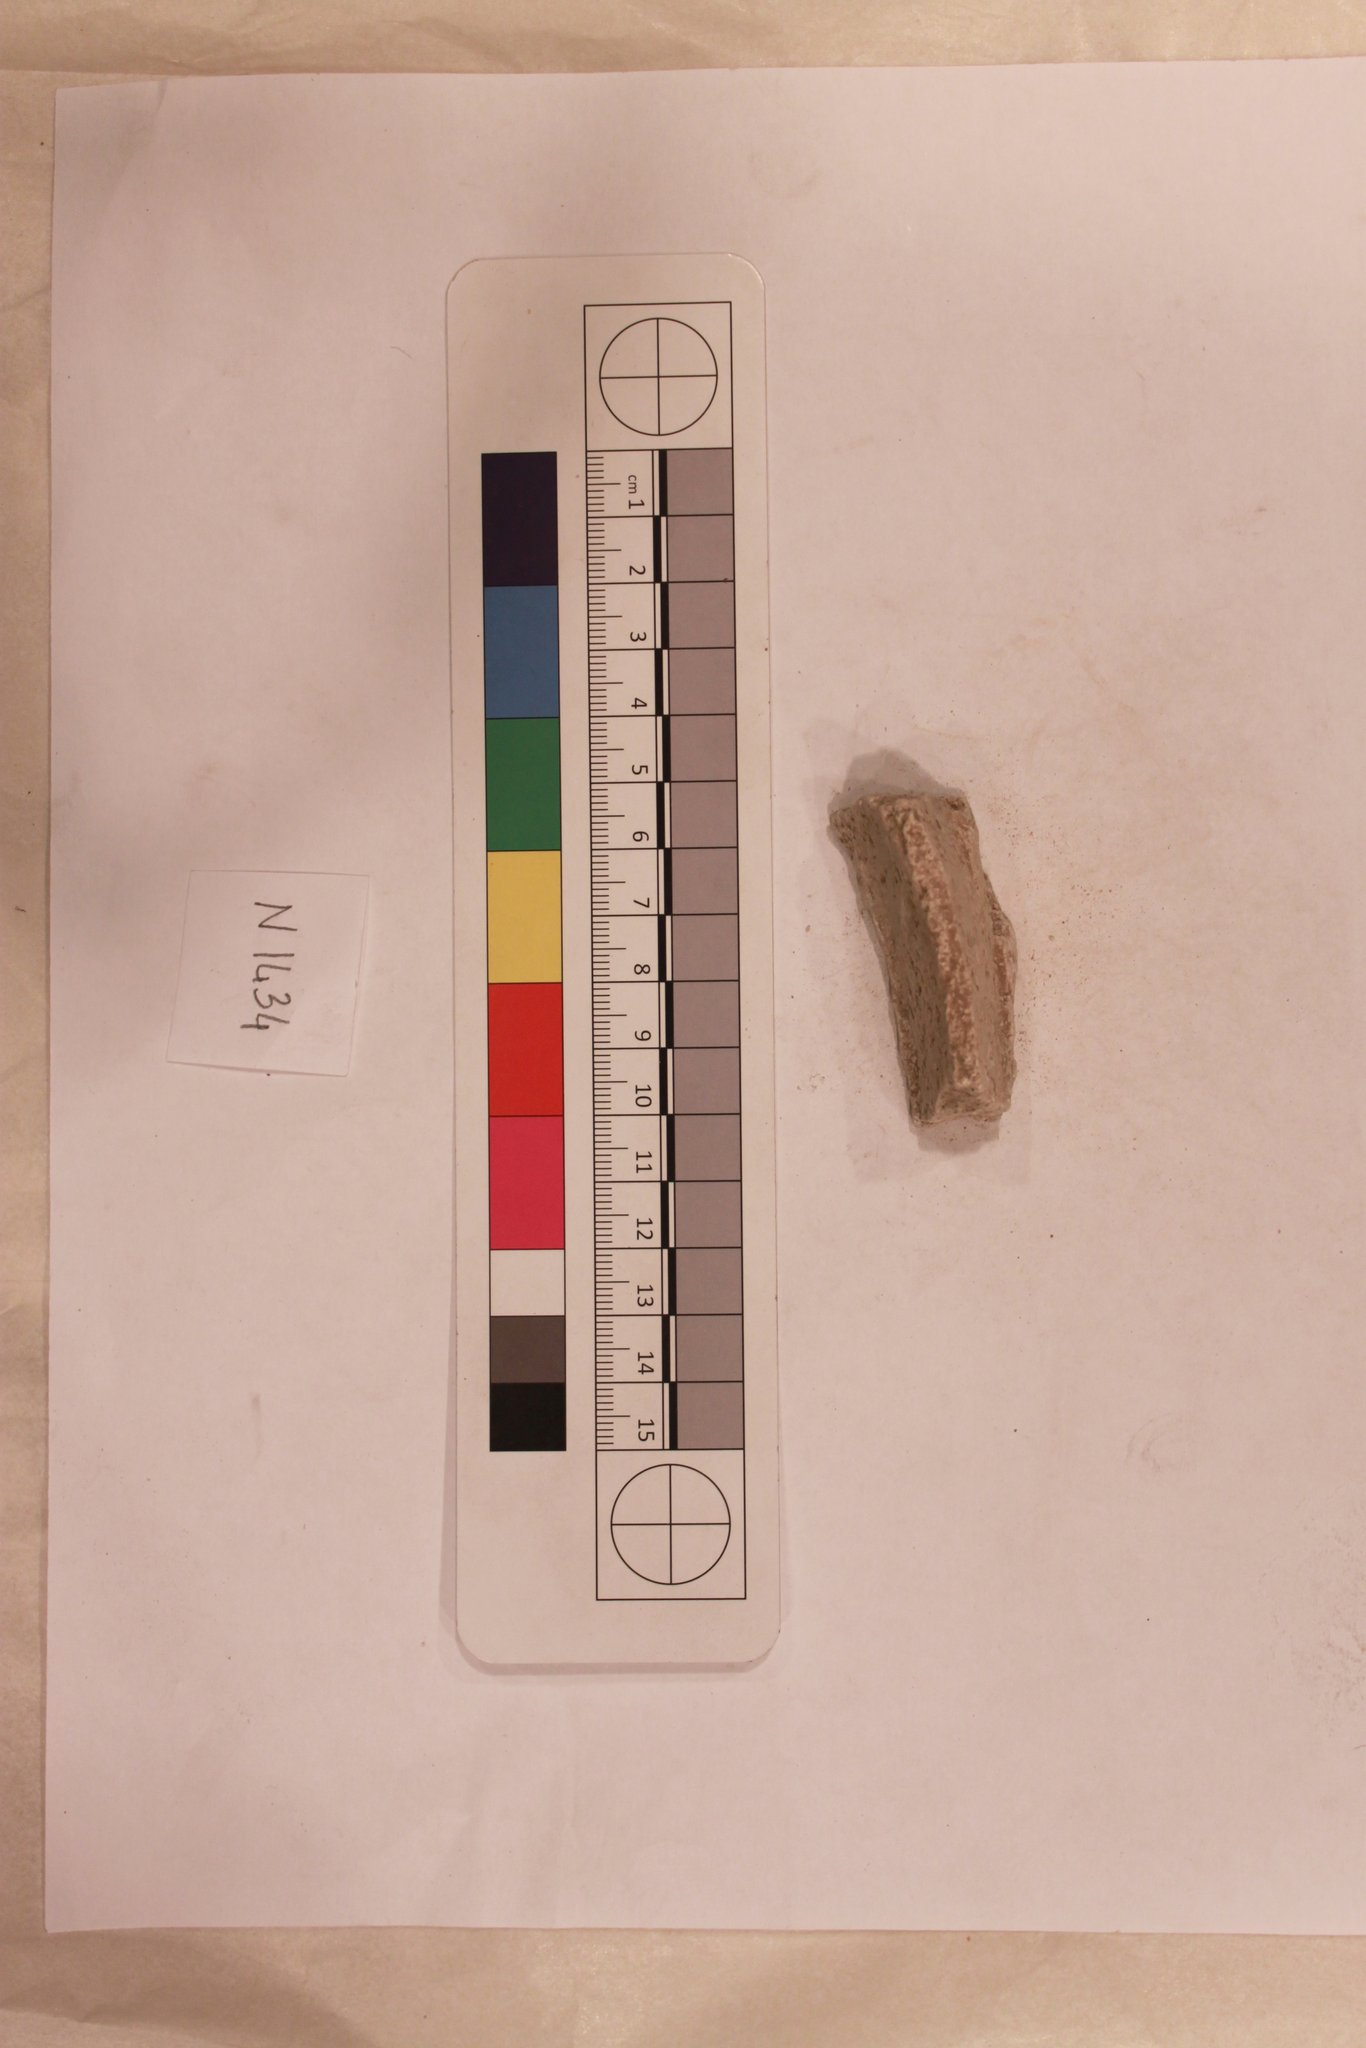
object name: fragment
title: Stucco Fragment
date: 701-1200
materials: plaster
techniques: carving, painting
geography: iran